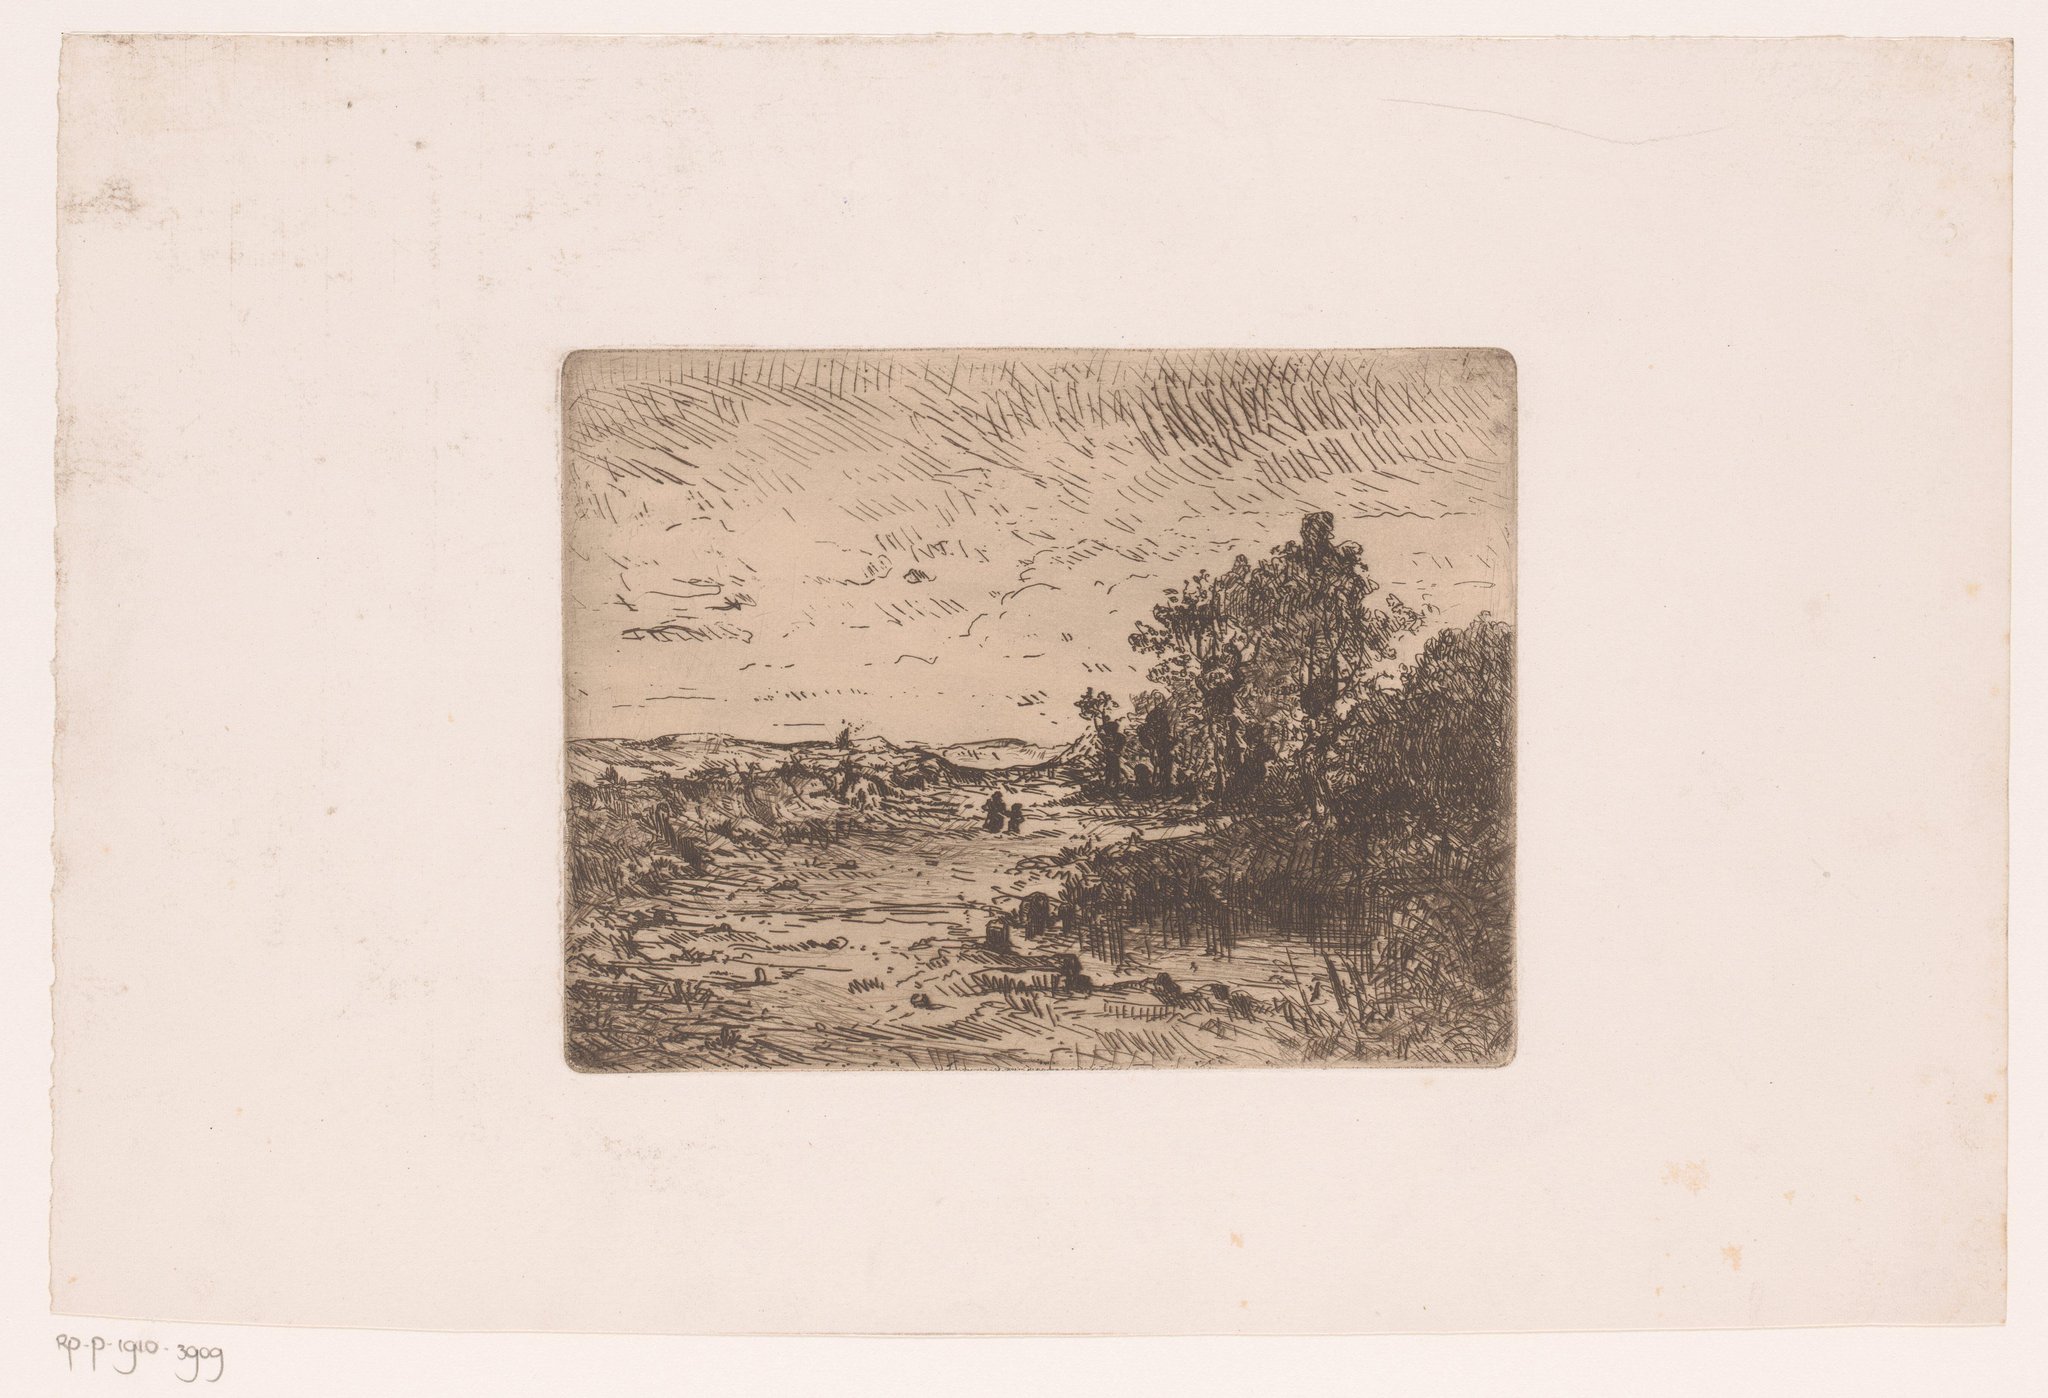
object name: print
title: Landschap met vrouw en kind op een pad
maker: louis adolphe jacobs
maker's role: painter, print maker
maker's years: 1855-1929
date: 1865-1910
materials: paper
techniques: etching, intaglio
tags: landscapes in the temperate zone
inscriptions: collector's mark: Lugt 2228